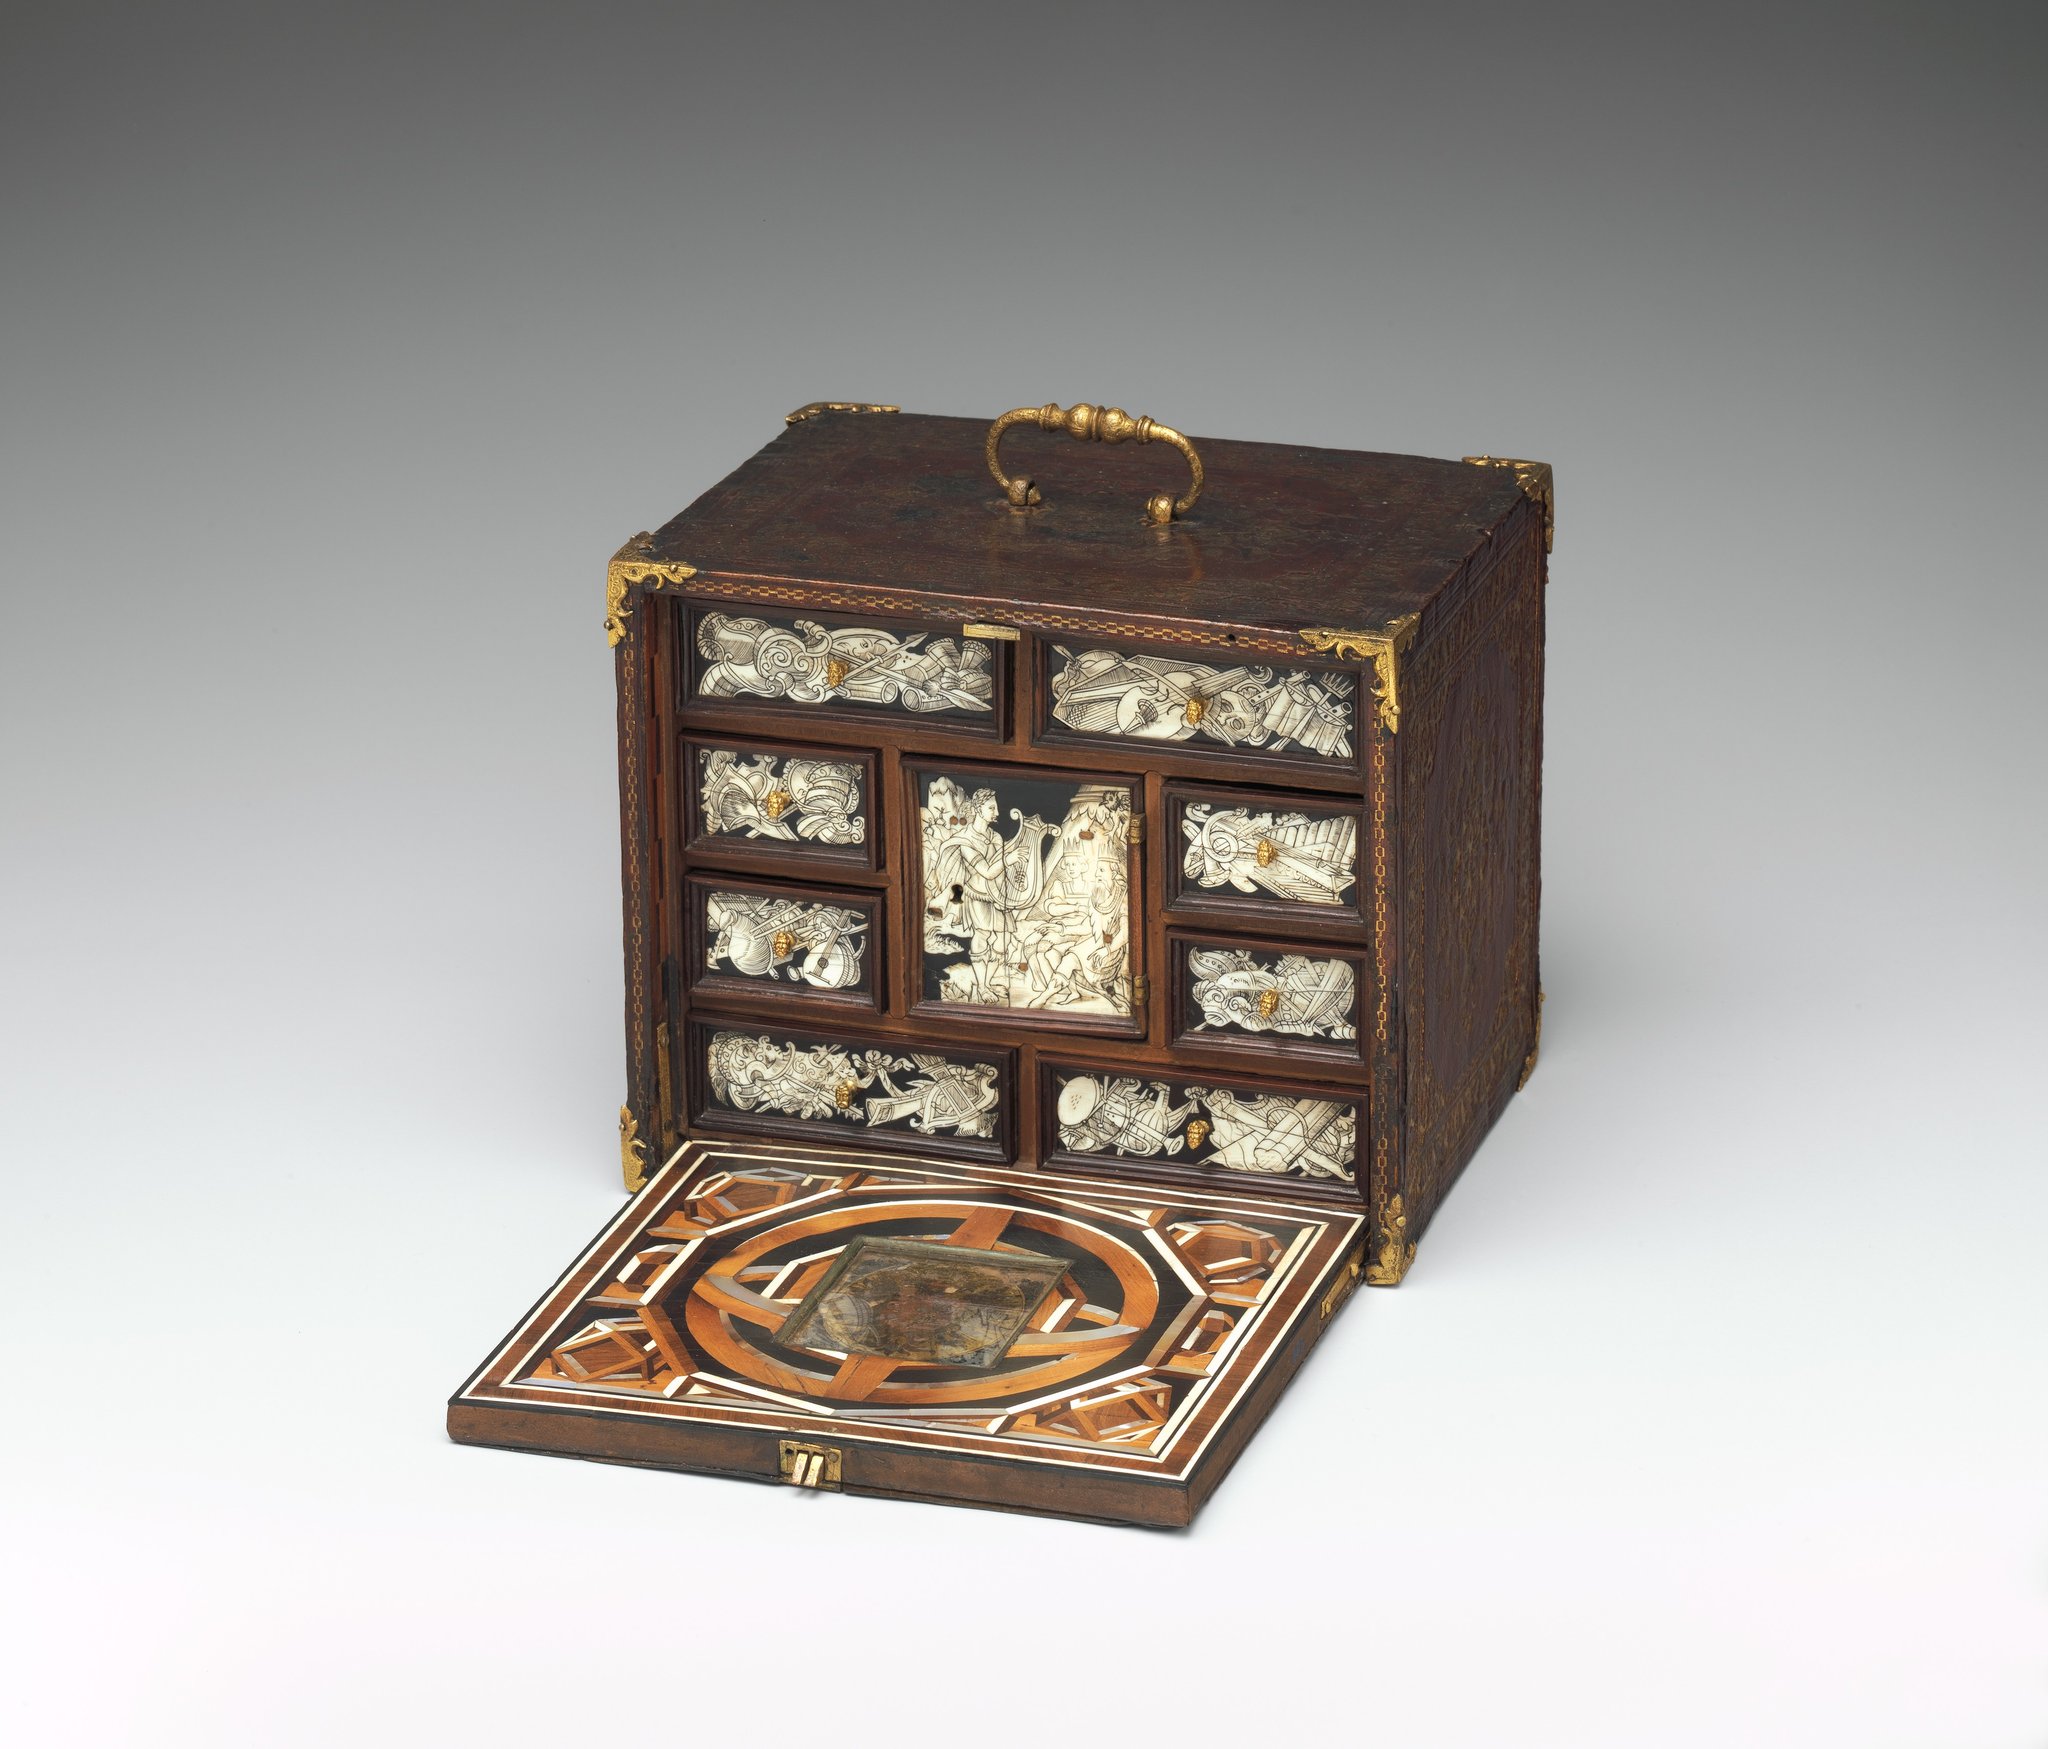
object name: cabinet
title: Miniature collector's cabinet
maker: bernard salomon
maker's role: designer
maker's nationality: french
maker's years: 1508-1561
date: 1600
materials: wood, glass, gold, ivory, leather, metal, mother of pearl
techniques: dyeing, gilding, painting, stain, tooling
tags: musical instruments,orpheus,pluto